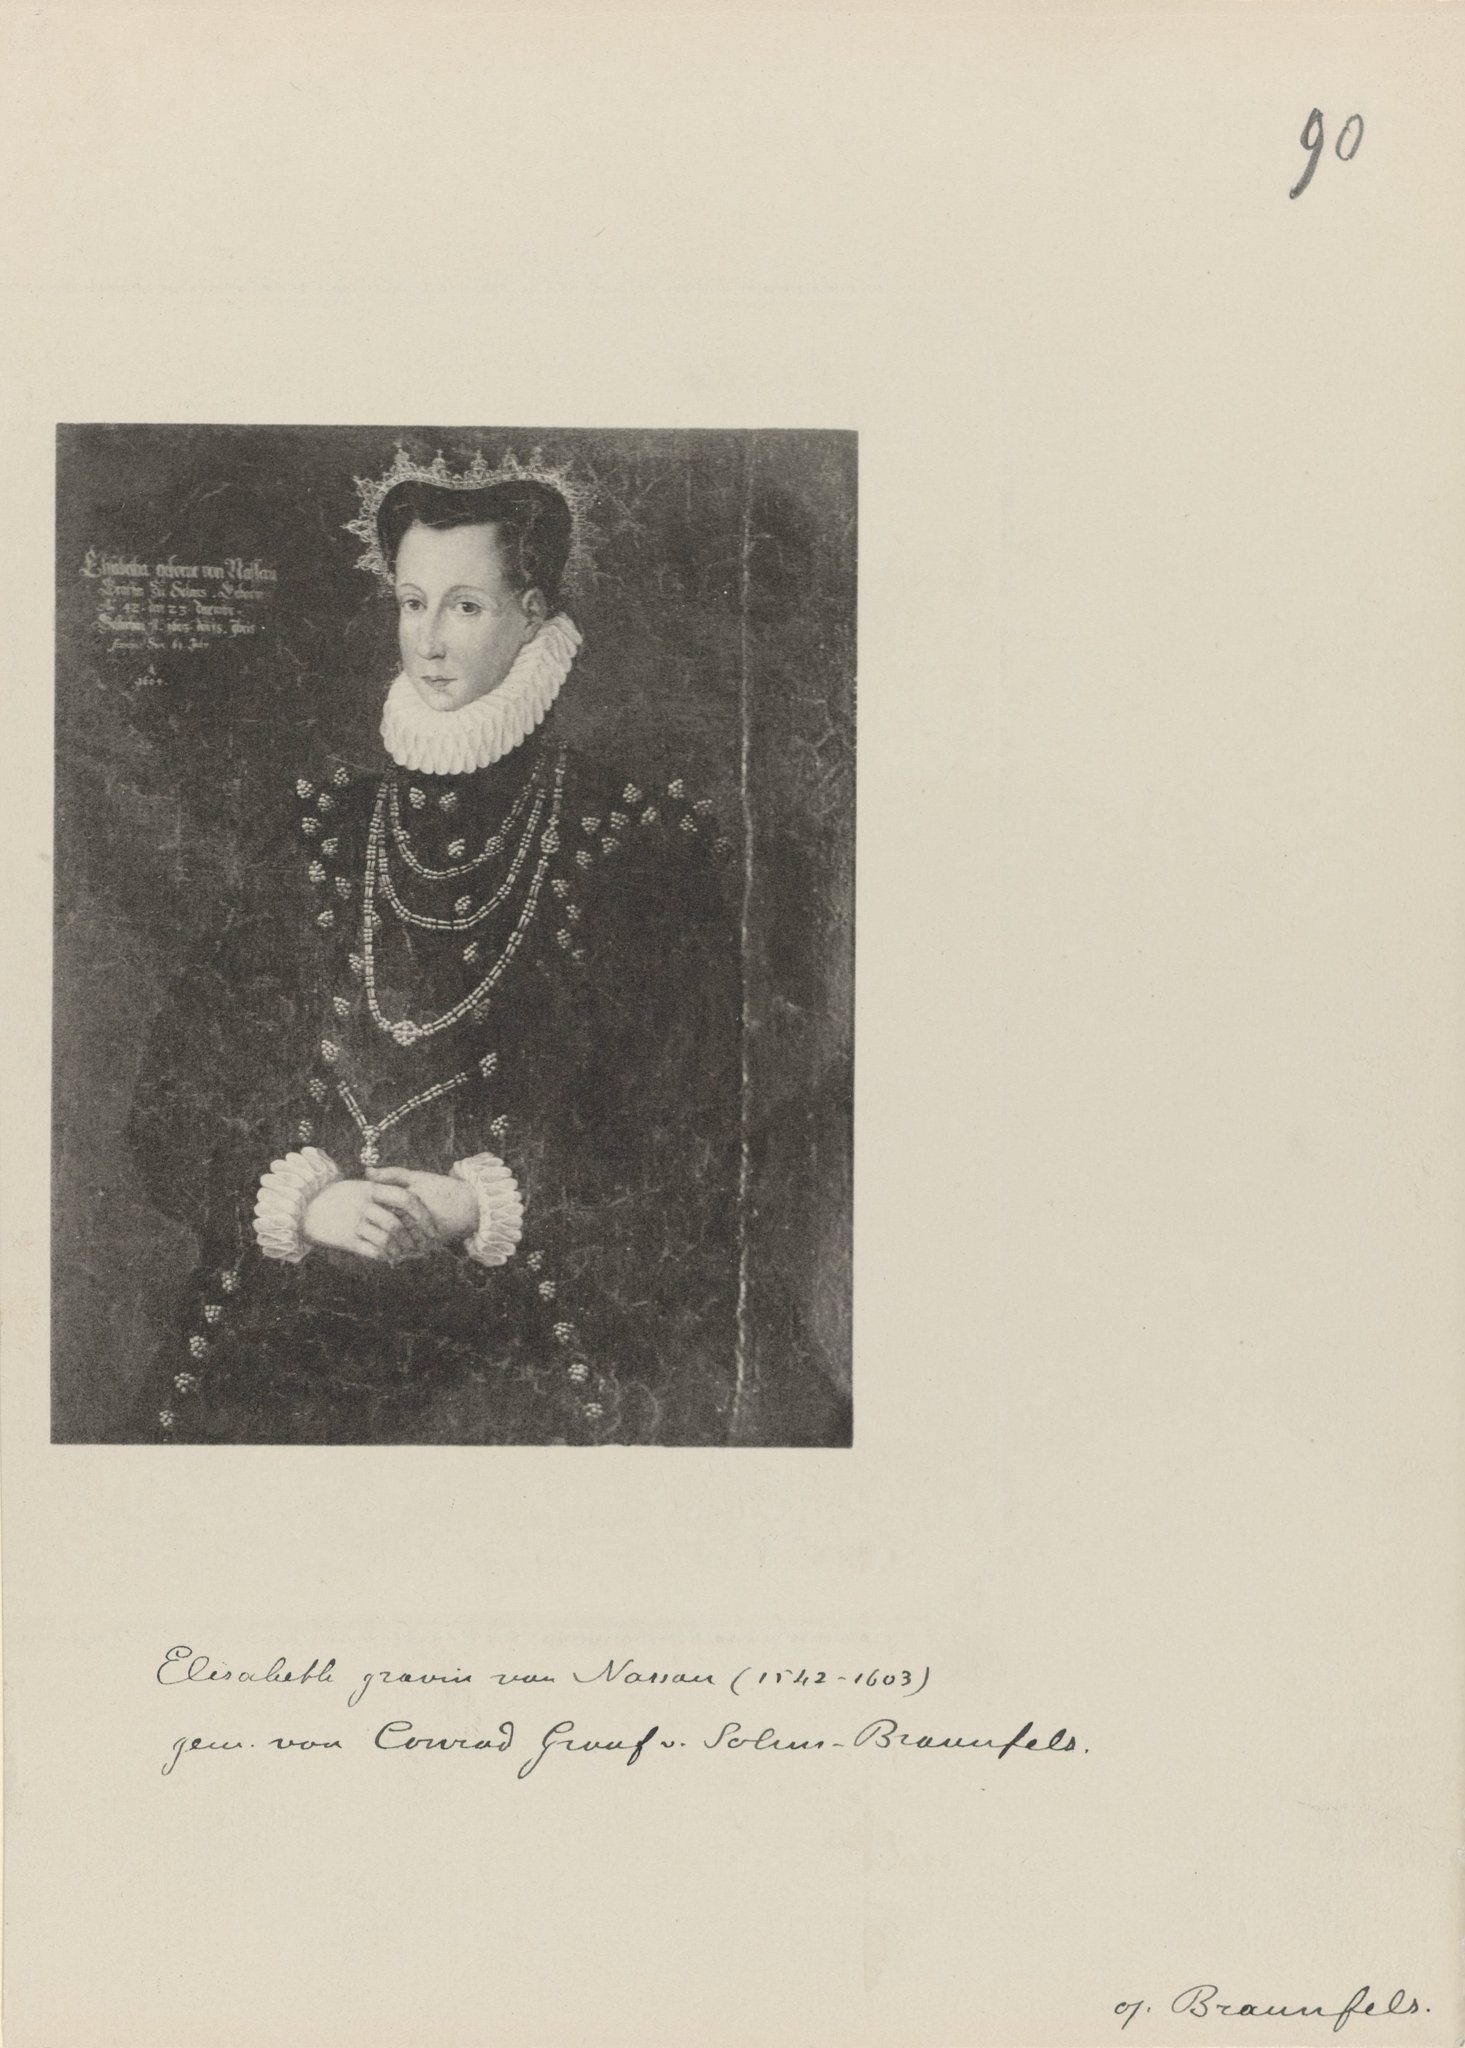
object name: photomechanical print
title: Portret van Elisabeth, gravin van Nassau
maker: Anonymous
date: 1850-1949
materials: paper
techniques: photochemical processes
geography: netherlands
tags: dillenburg, elisabeth gravin van nassau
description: De hier vermelde titel verwijst naar de hoogst verkregen titel van de geportretteerde, niet per se naar de titel die de geportretteerde op deze voorstelling draagt.